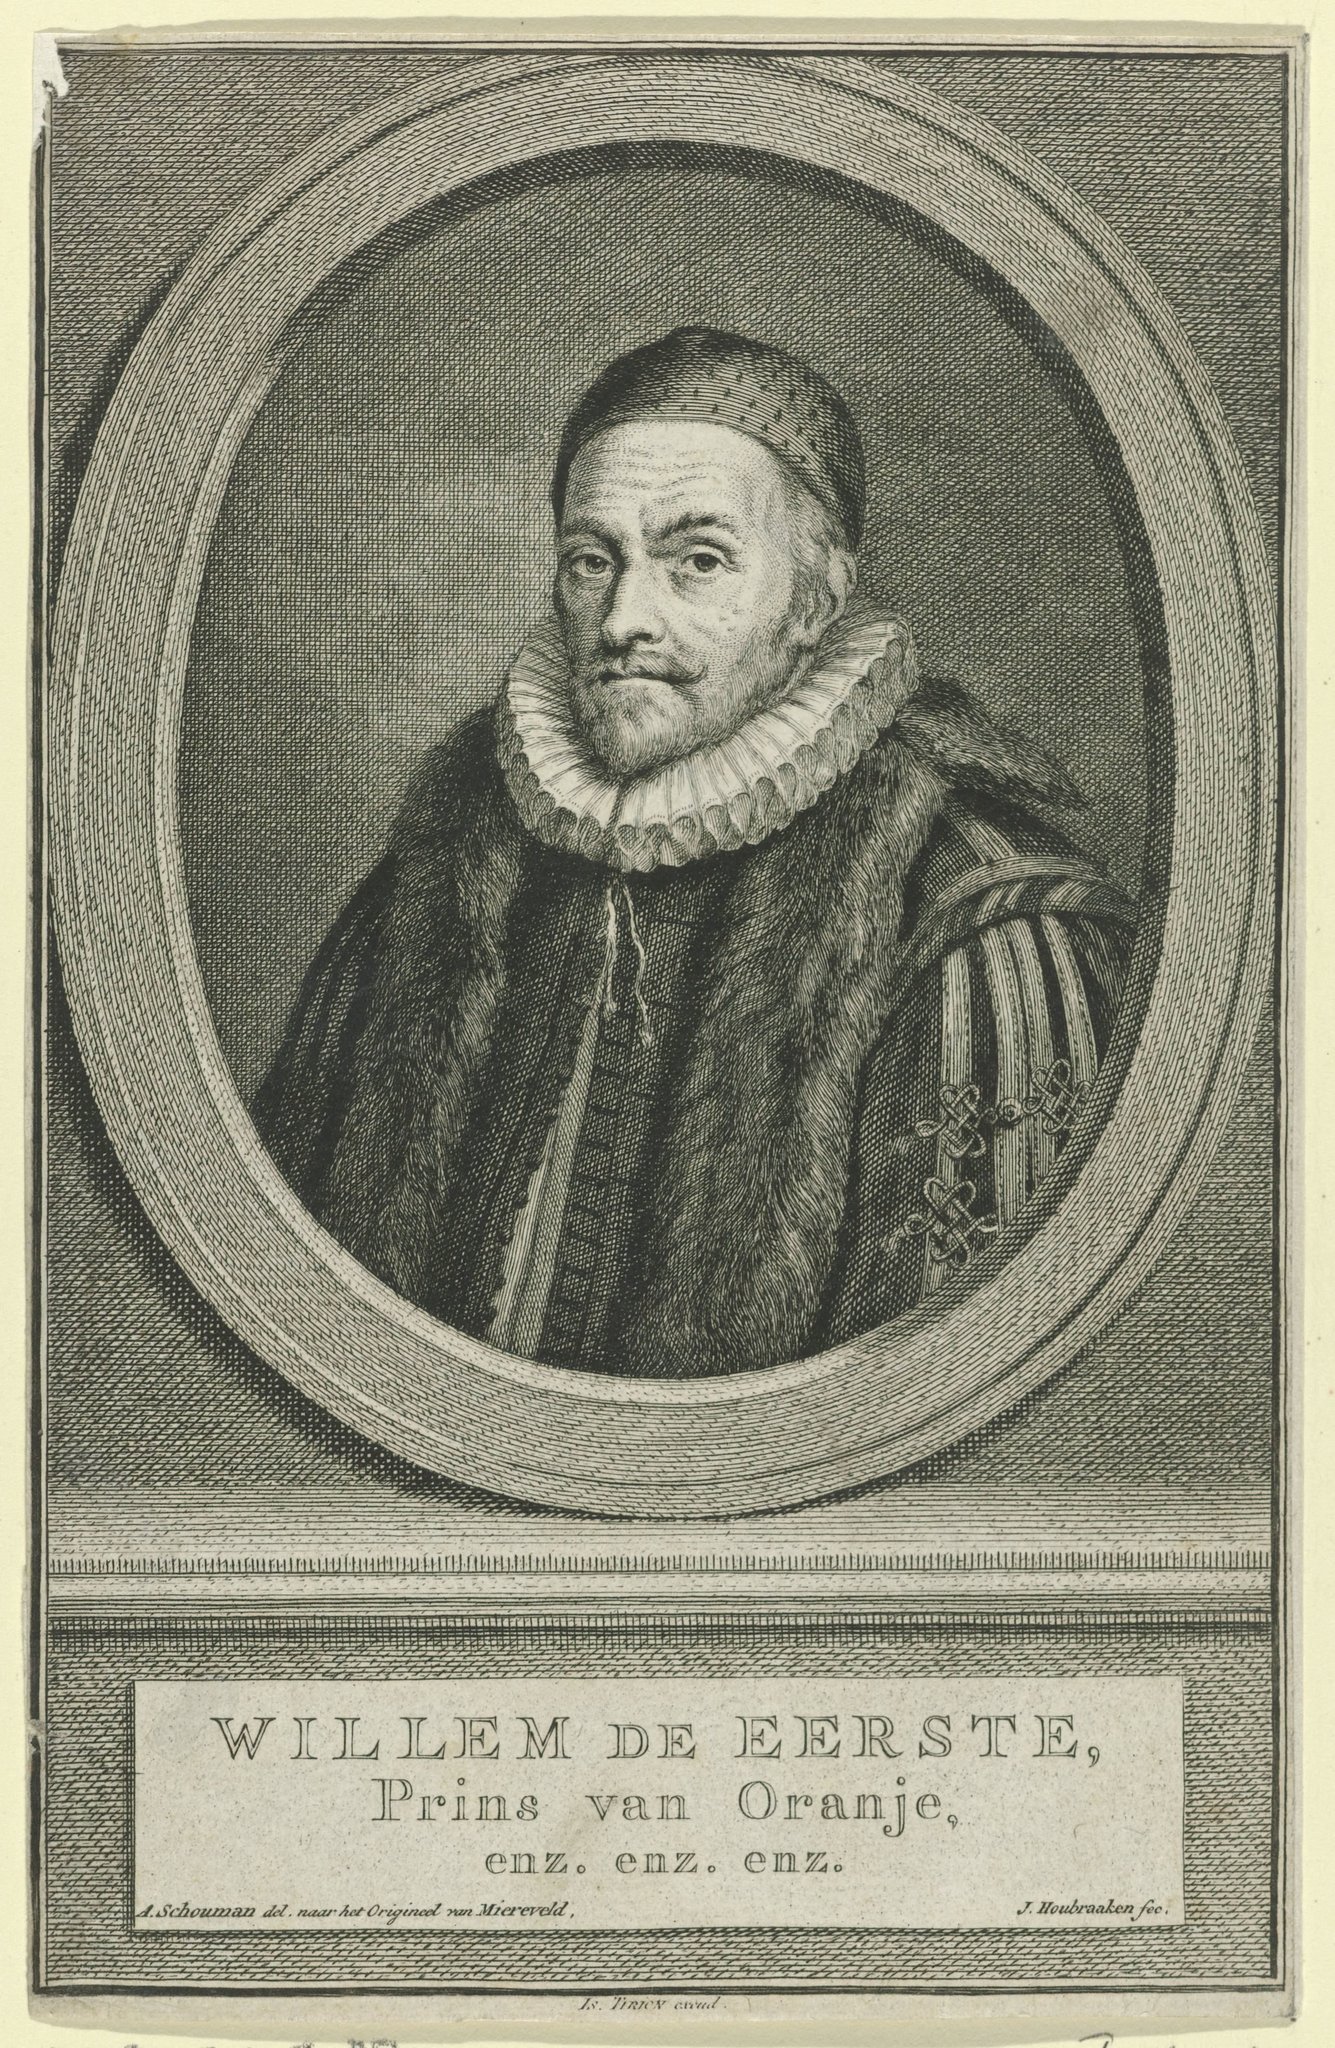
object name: book illustration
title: Portret van Willem I, prins van Oranje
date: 1749-1759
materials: paper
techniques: engraving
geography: amsterdam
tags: delft, william i (prince of orange)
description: De hier vermelde titel verwijst naar de hoogst verkregen titel van de geportretteerde, niet per se naar de titel die de geportretteerde op deze voorstelling draagt. Prent uit: Wagenaar, Jan. Vaderlandsche historie. Amsterdam: Isaak Tirion, 1749-1759.